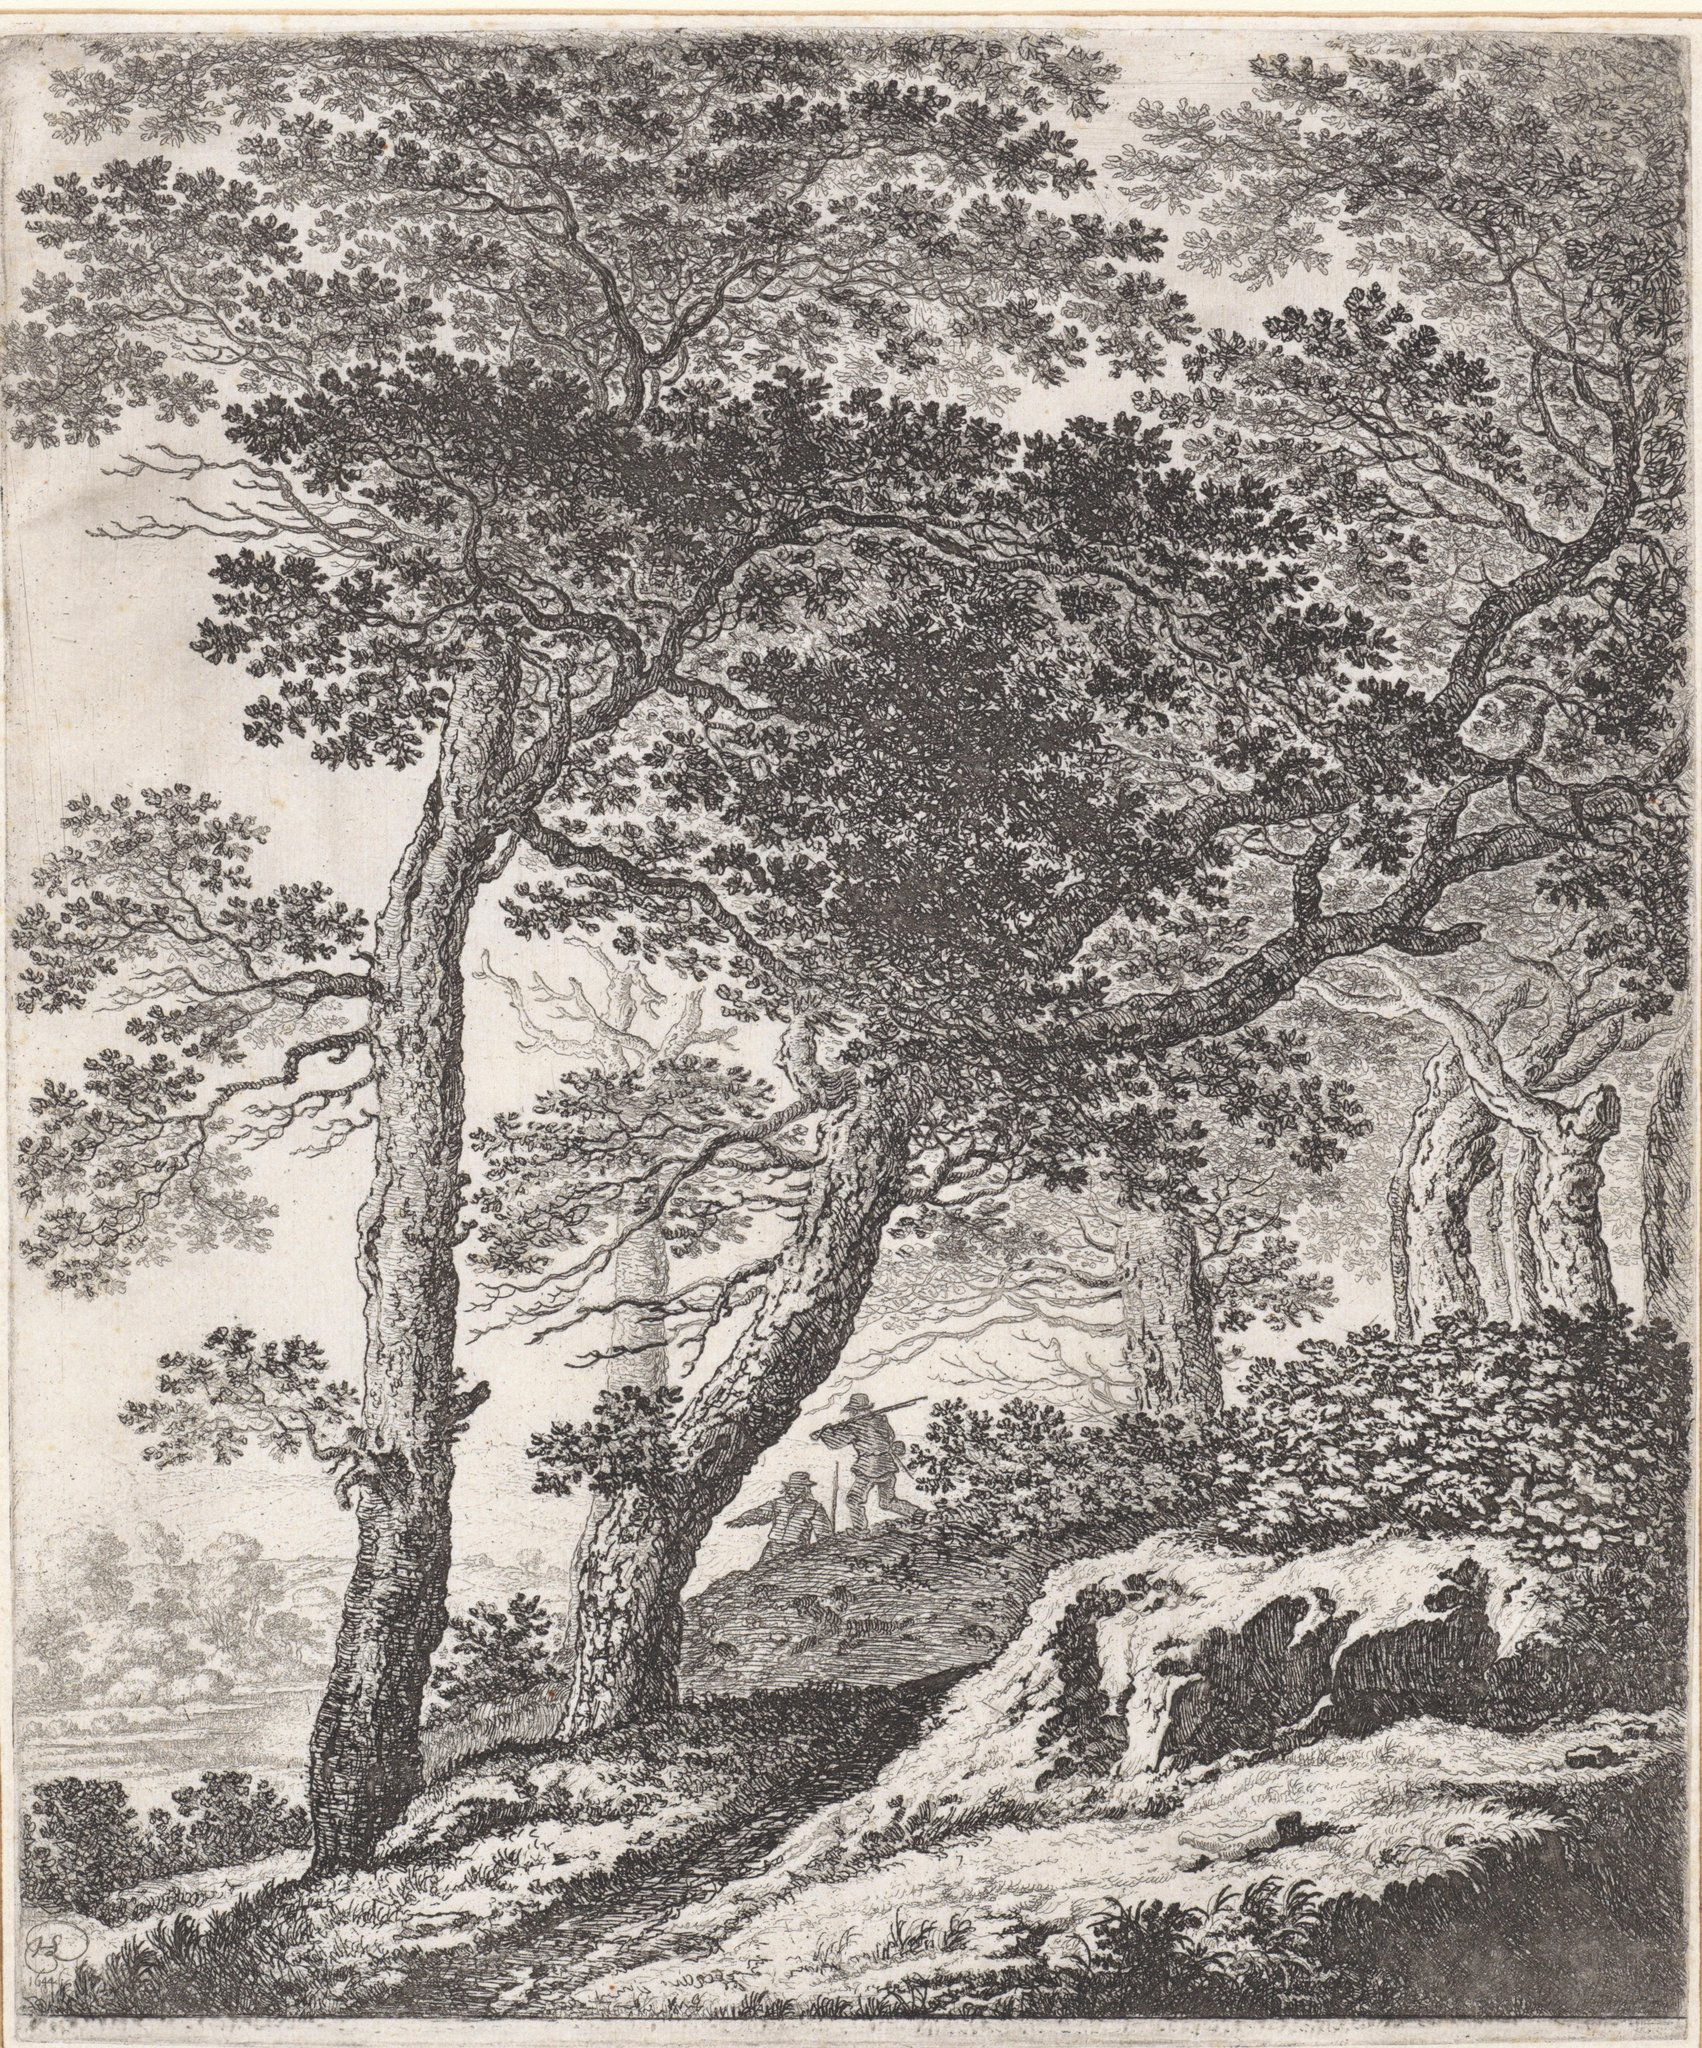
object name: print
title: Heuvellandschap met jagers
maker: herman saftleven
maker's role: draughtsman, painter, print maker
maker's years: 1609-1685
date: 1644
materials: paper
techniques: etching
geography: utrecht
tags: low hill country, hunter, forest, wood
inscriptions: collector's mark: Lugt 240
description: In een heuvelachtig landschap lopen twee jagers tussen het geboomte van de bosrand.